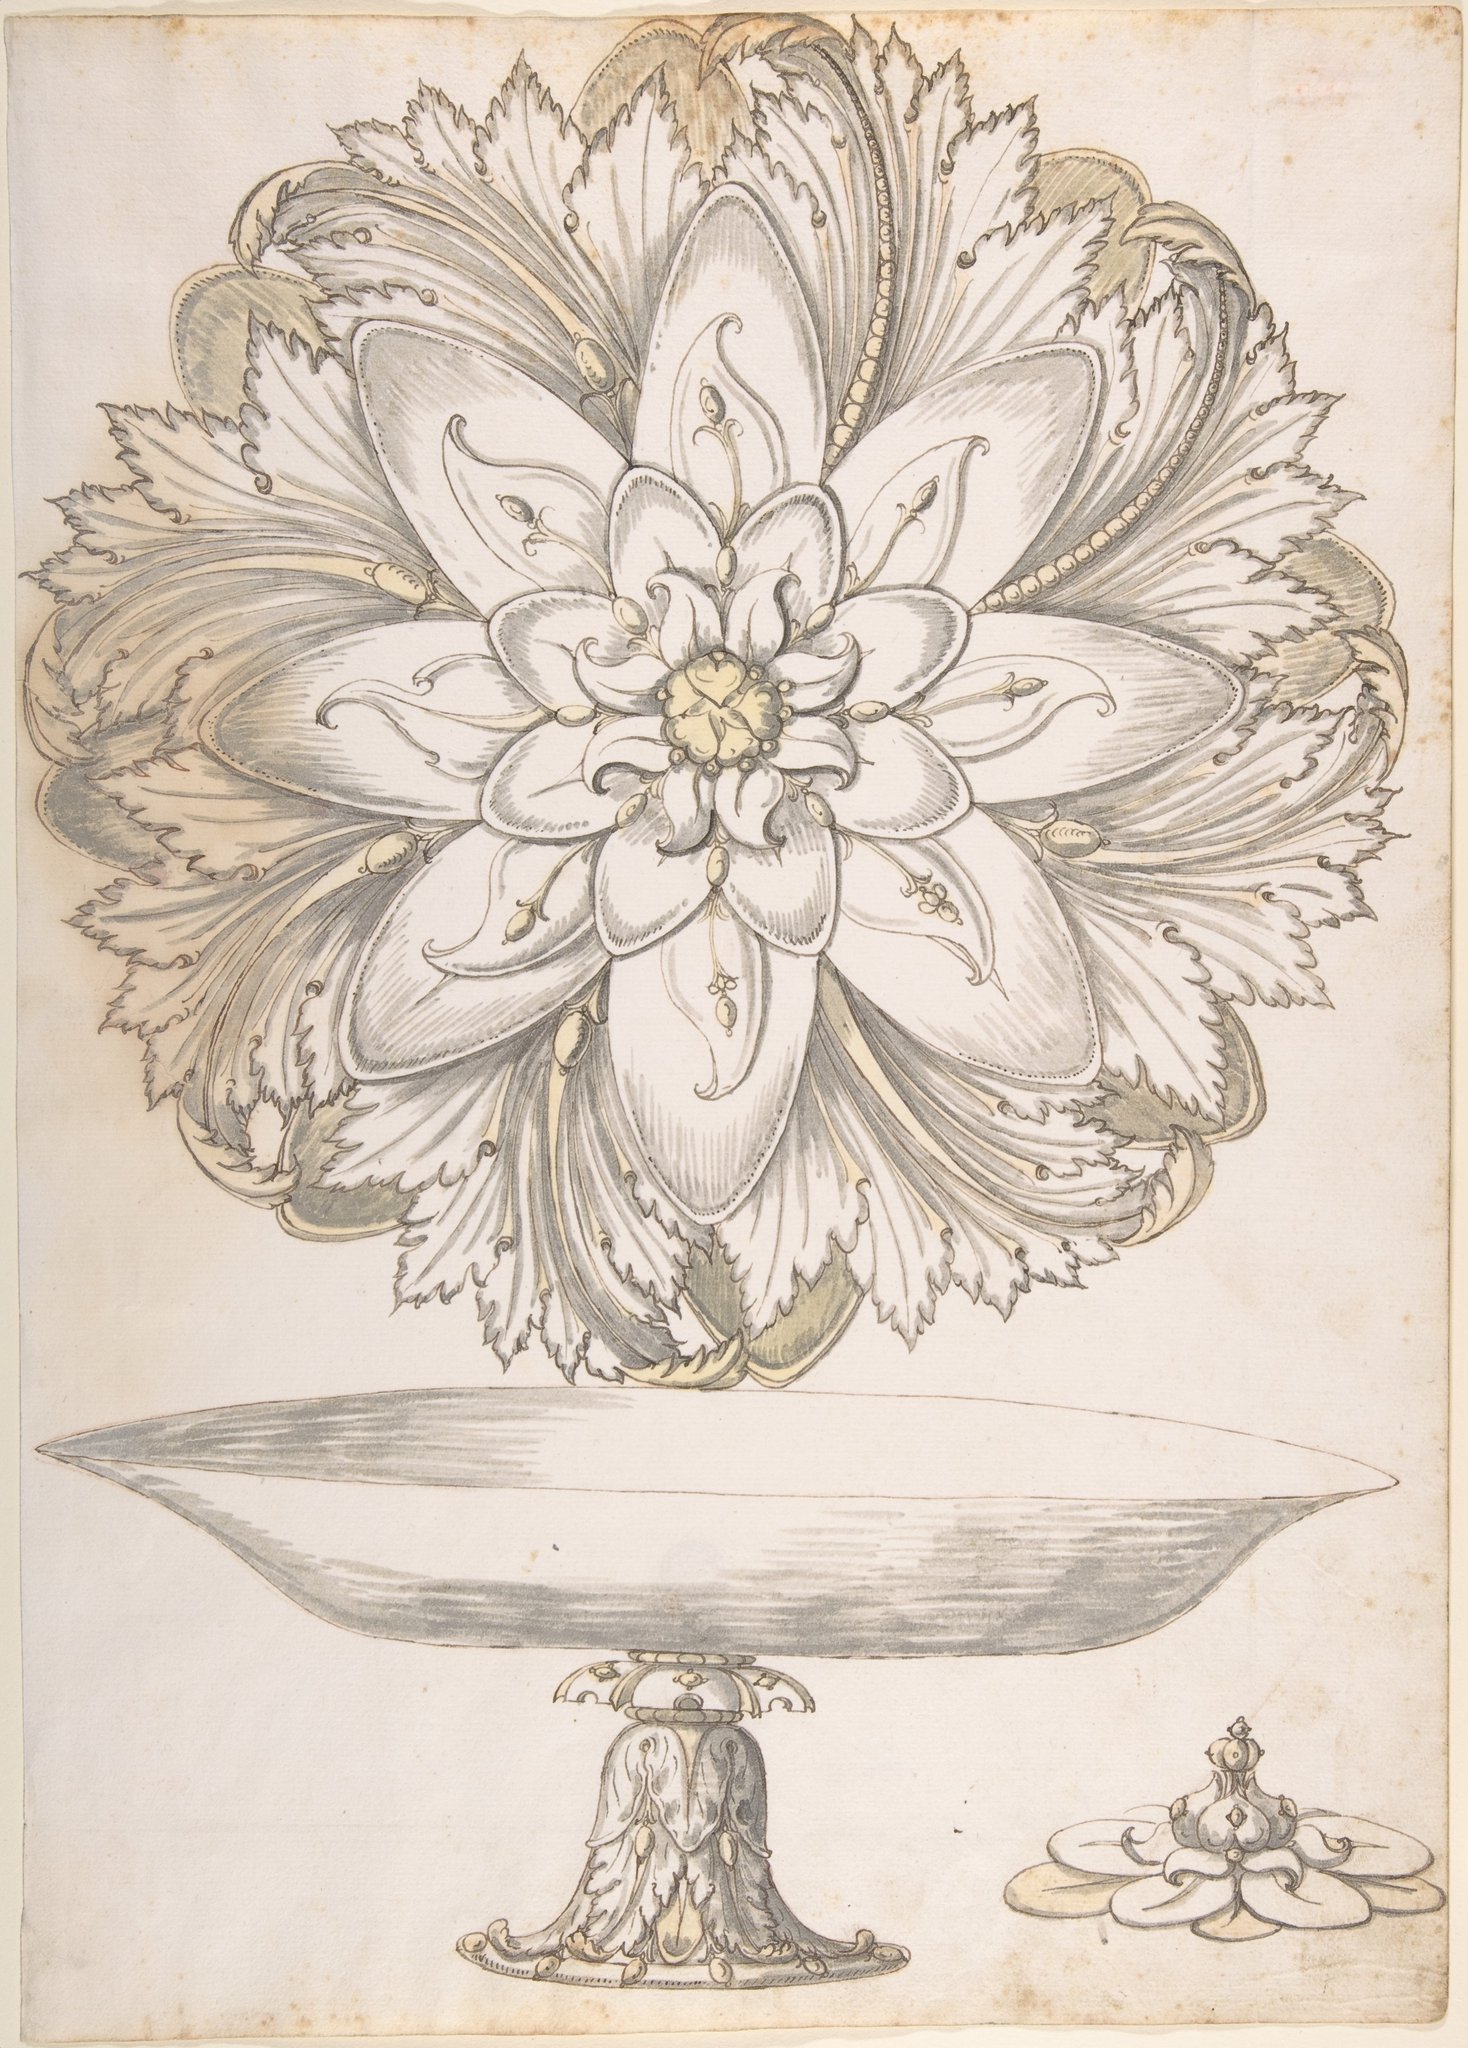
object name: drawing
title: Design for Single Footed Dish with Cover Shaped like Flower and Foliage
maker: erasmus hornick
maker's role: artist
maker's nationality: netherlandish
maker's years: 1501-1583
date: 1501-1600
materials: chalk, ink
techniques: brush, pen, wash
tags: flowers,dishes